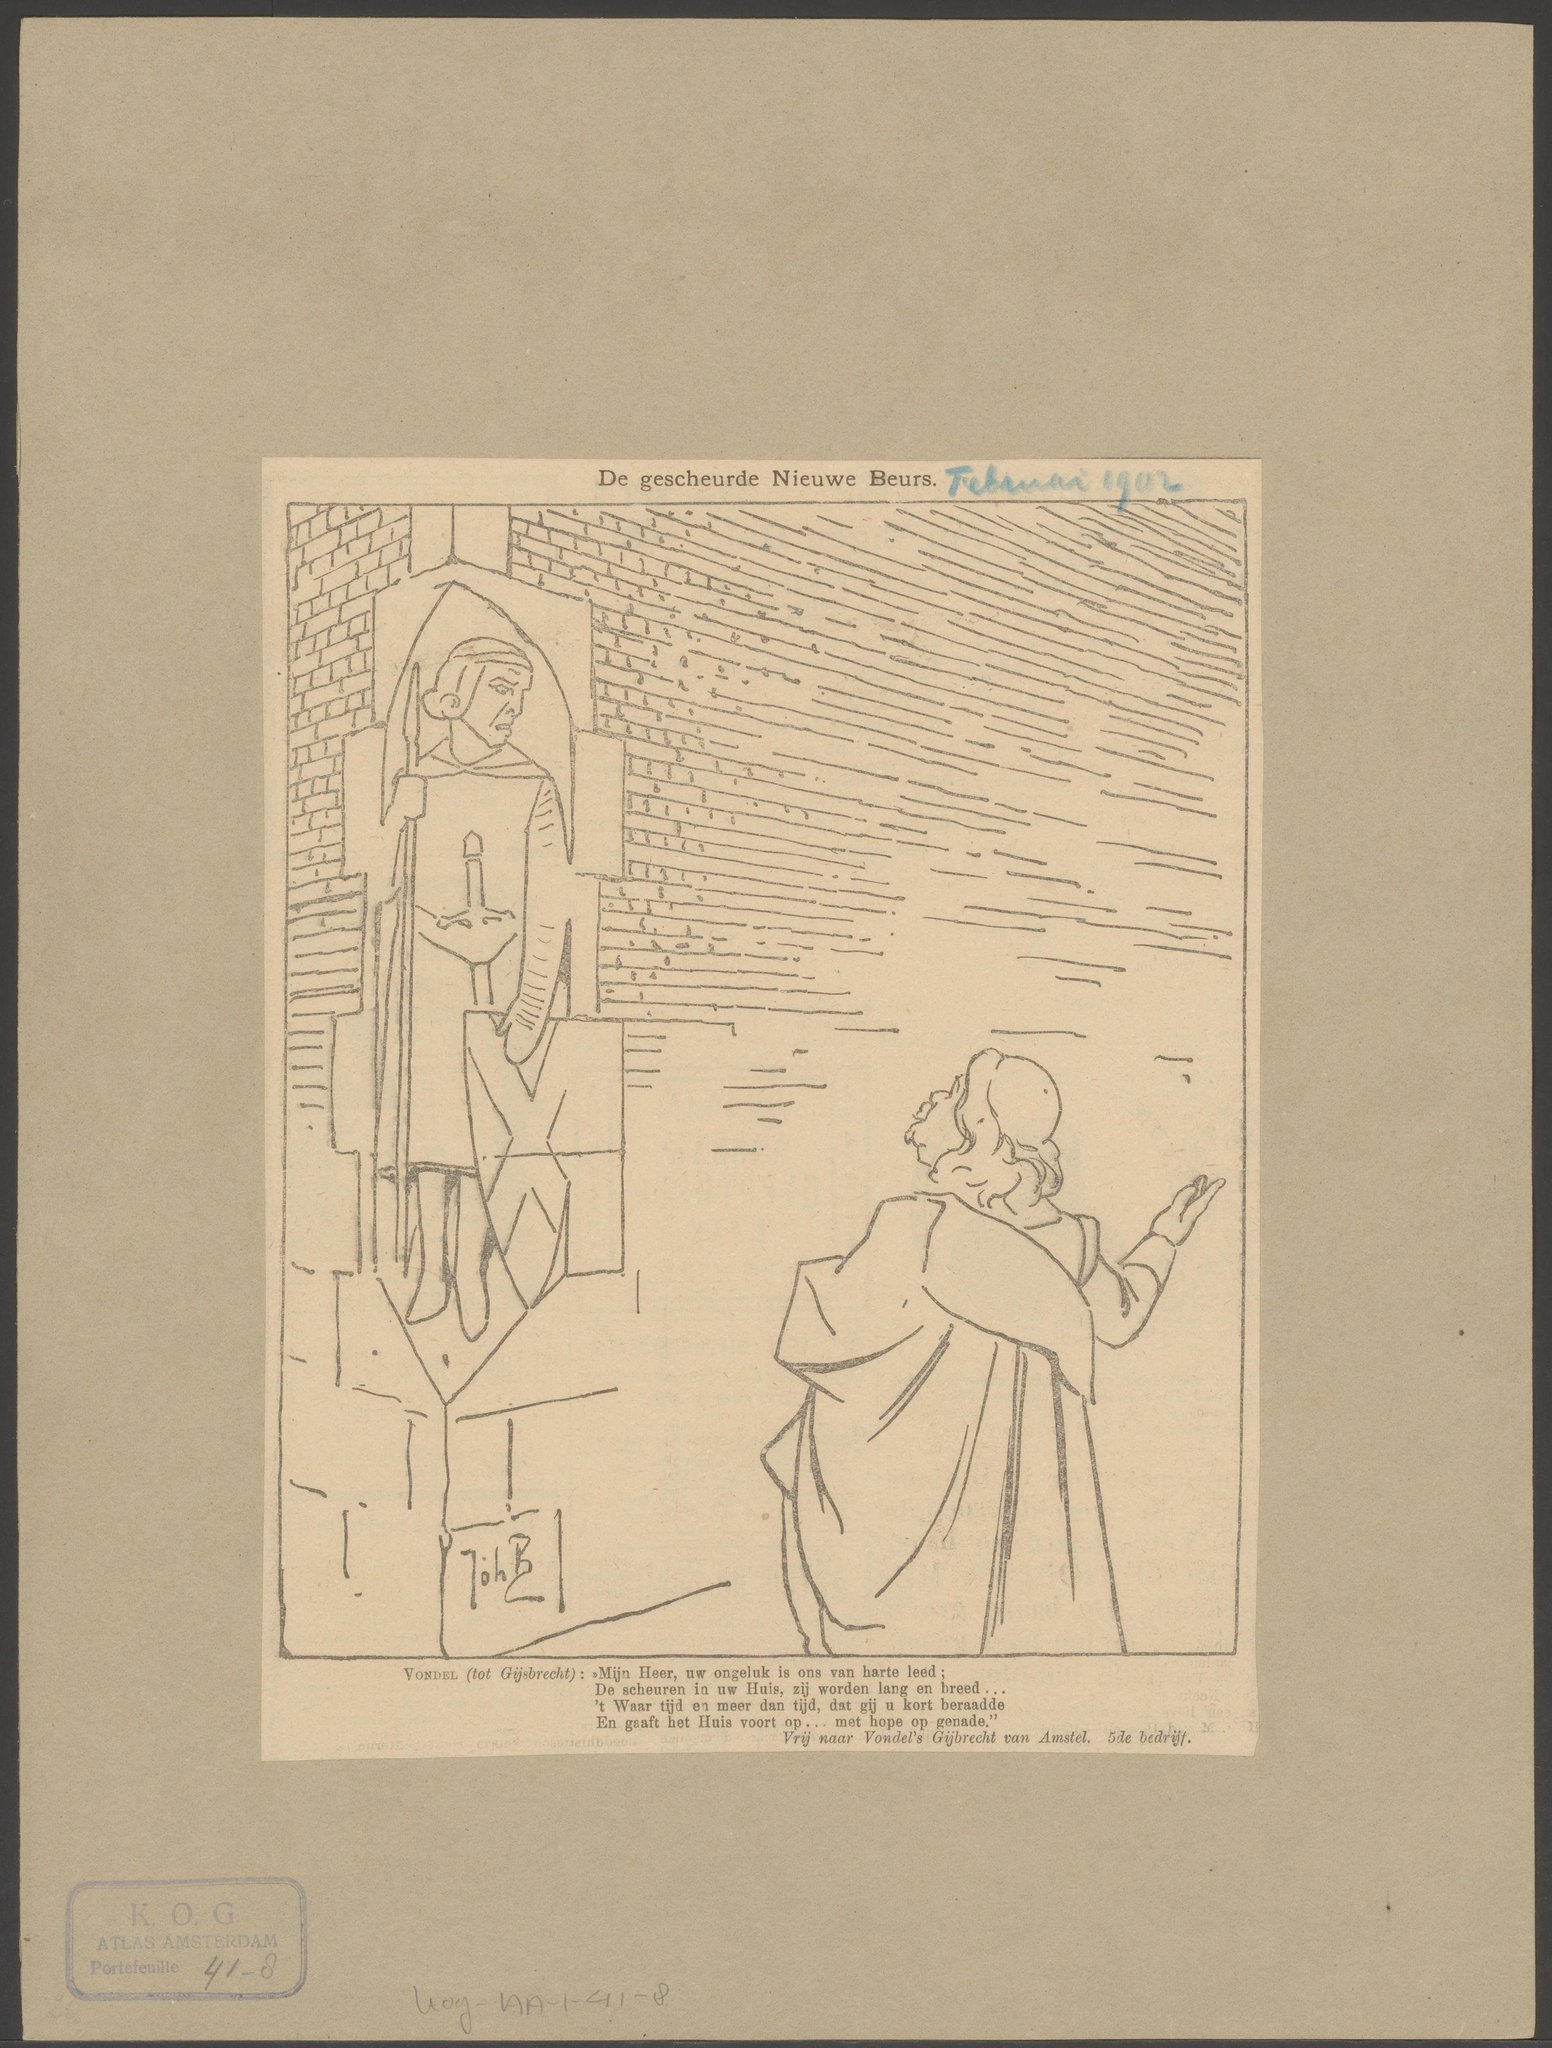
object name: photomechanical print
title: Vondel spreekt tegen het beeld van Gijsbrecht van Amstel op de Beurs van Berlage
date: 1902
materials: paper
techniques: letterpress printing, line block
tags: cologne, amsterdam, joost van den vondel, stock exchange, stock-market, architecture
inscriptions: collector's mark: Lugt 1461b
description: Onderwerpsrubriek binnen de Atlas Amsterdam: B. Beurs op het Damrak.